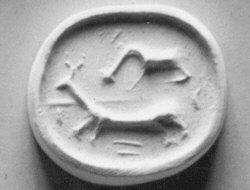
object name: stamp seal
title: Stamp seal (ovoid) with animals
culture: syro-anatolian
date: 1200-601 BCE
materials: stone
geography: northern syria or southeastern anatolia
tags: animals